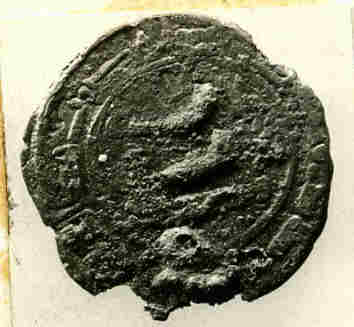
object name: coin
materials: copper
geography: iran